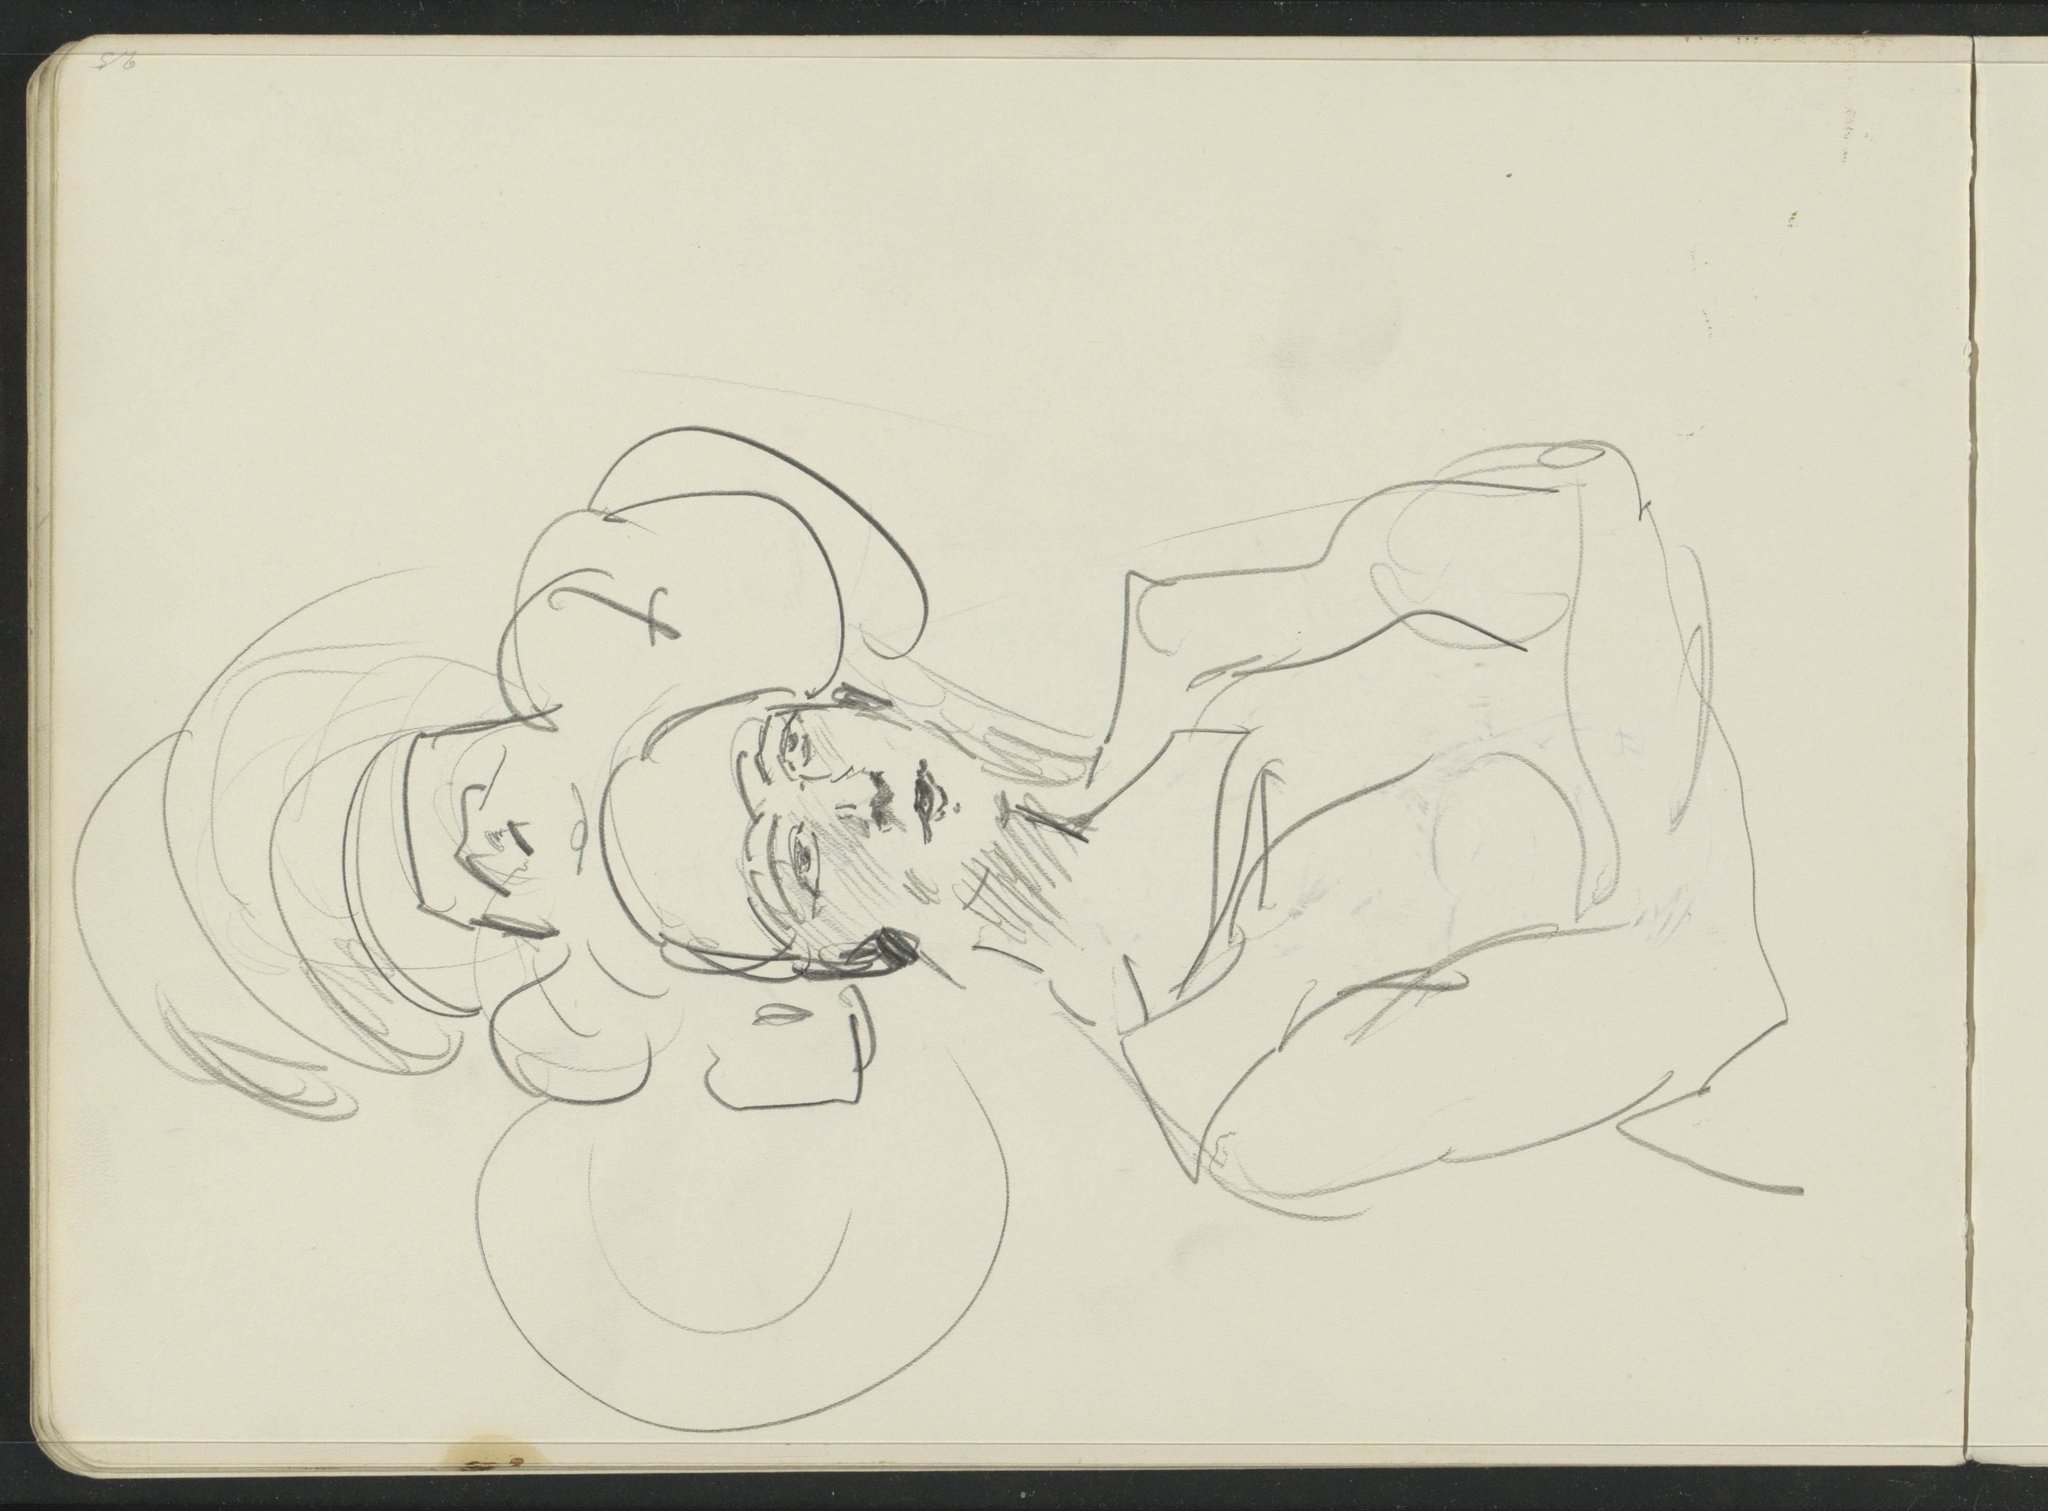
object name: sketchbook leaf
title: Vrouw met hoofdtooi, mogelijk een revuedanseres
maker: isaac israels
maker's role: draughtsman, painter, print maker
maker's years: 1865-1934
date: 1915-1934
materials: paper, pencil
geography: the hague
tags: adult woman, female dancer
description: Blad 20 verso uit schetsboek XV met 22 bladen.